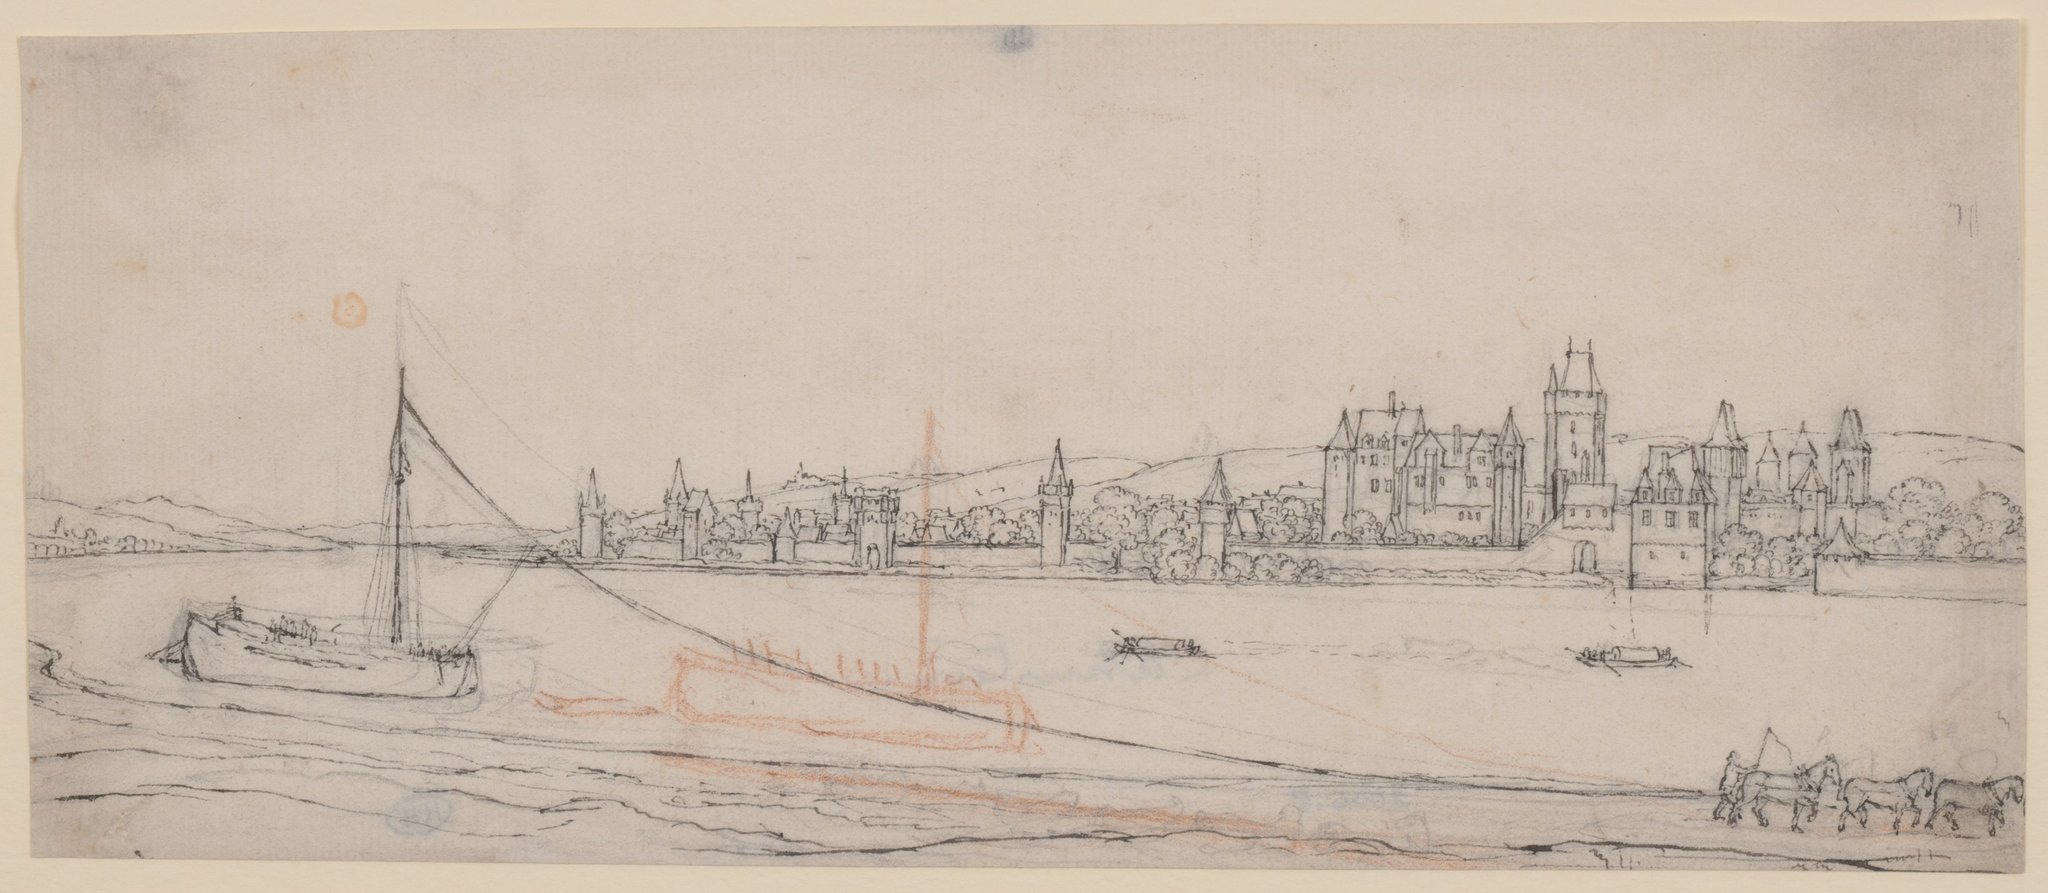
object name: drawing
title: View of Lahnstein on the River Rhine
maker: wenceslaus hollar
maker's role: artist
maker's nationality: bohemian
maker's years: 1607-1677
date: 1636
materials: chalk, ink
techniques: pen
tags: buildings,rivers,boats